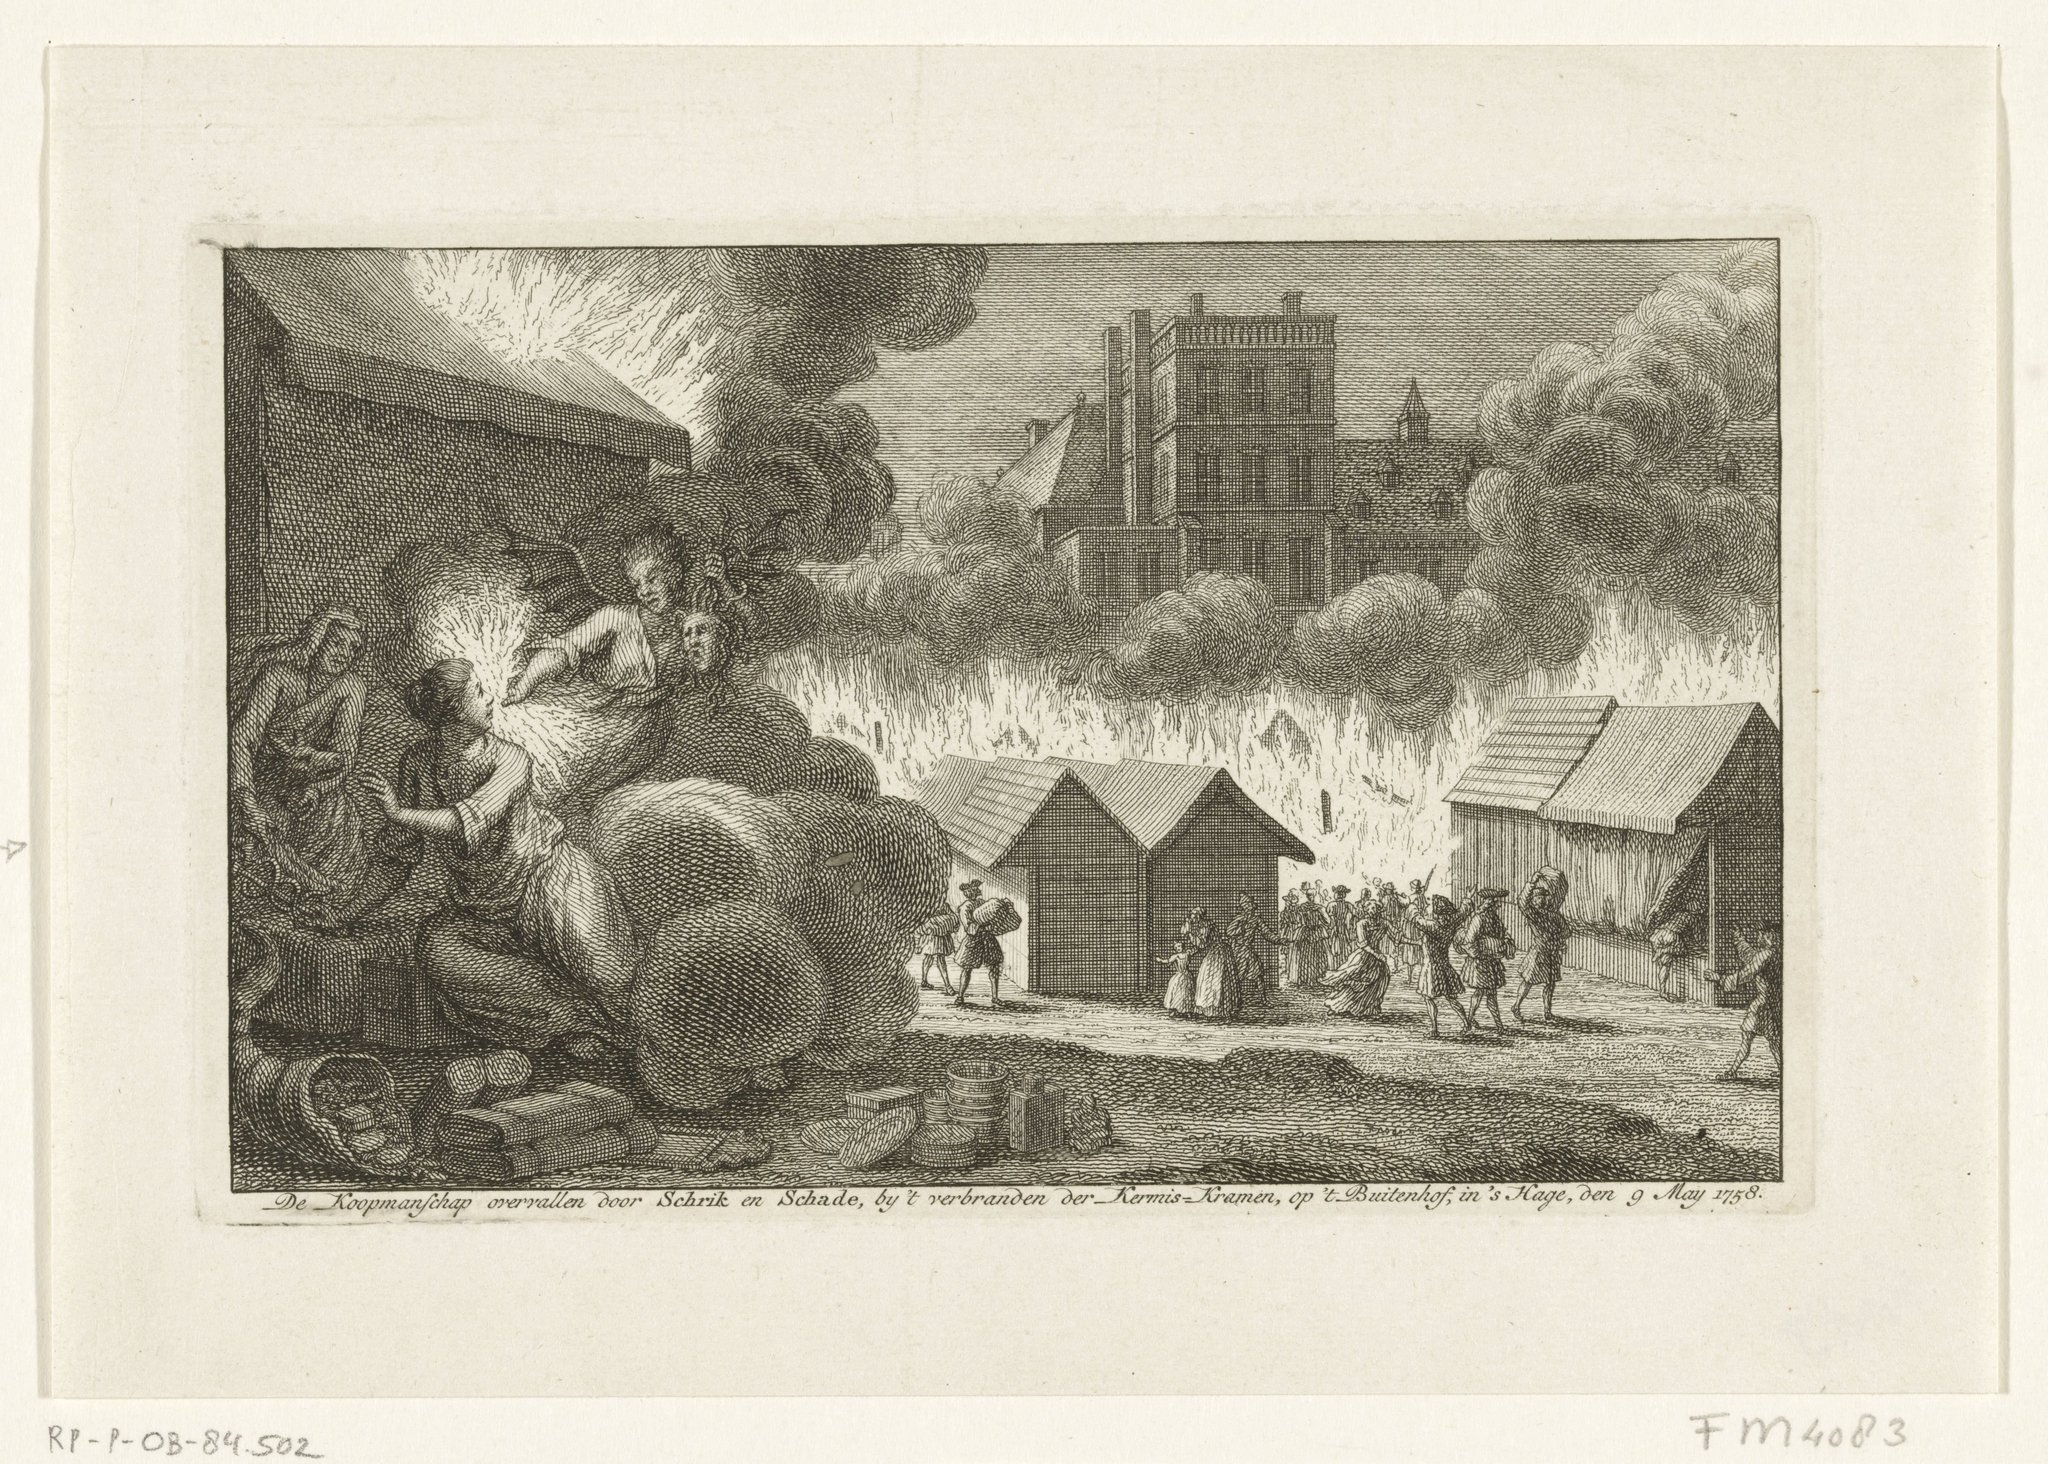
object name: print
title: Allegorie op de brand in de kermiskramen op het Buitenhof te Den Haag, 1758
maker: Anonymous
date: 1758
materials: paper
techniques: engraving, etching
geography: northern netherlands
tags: (annual) fair, trade fair, pleasure fair and circus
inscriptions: collector's mark: Lugt 2228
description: Allegorie op de brand in de kermiskramen op het Buitenhof te Den Haag, 9 mei 1758. Links wordt de personificatie van de Koopmanschap (met cadeucus) door een harpij met Meduskop de schrik aangejaagd. Op de achtergrond het Stadhouderlijk Kwartier.